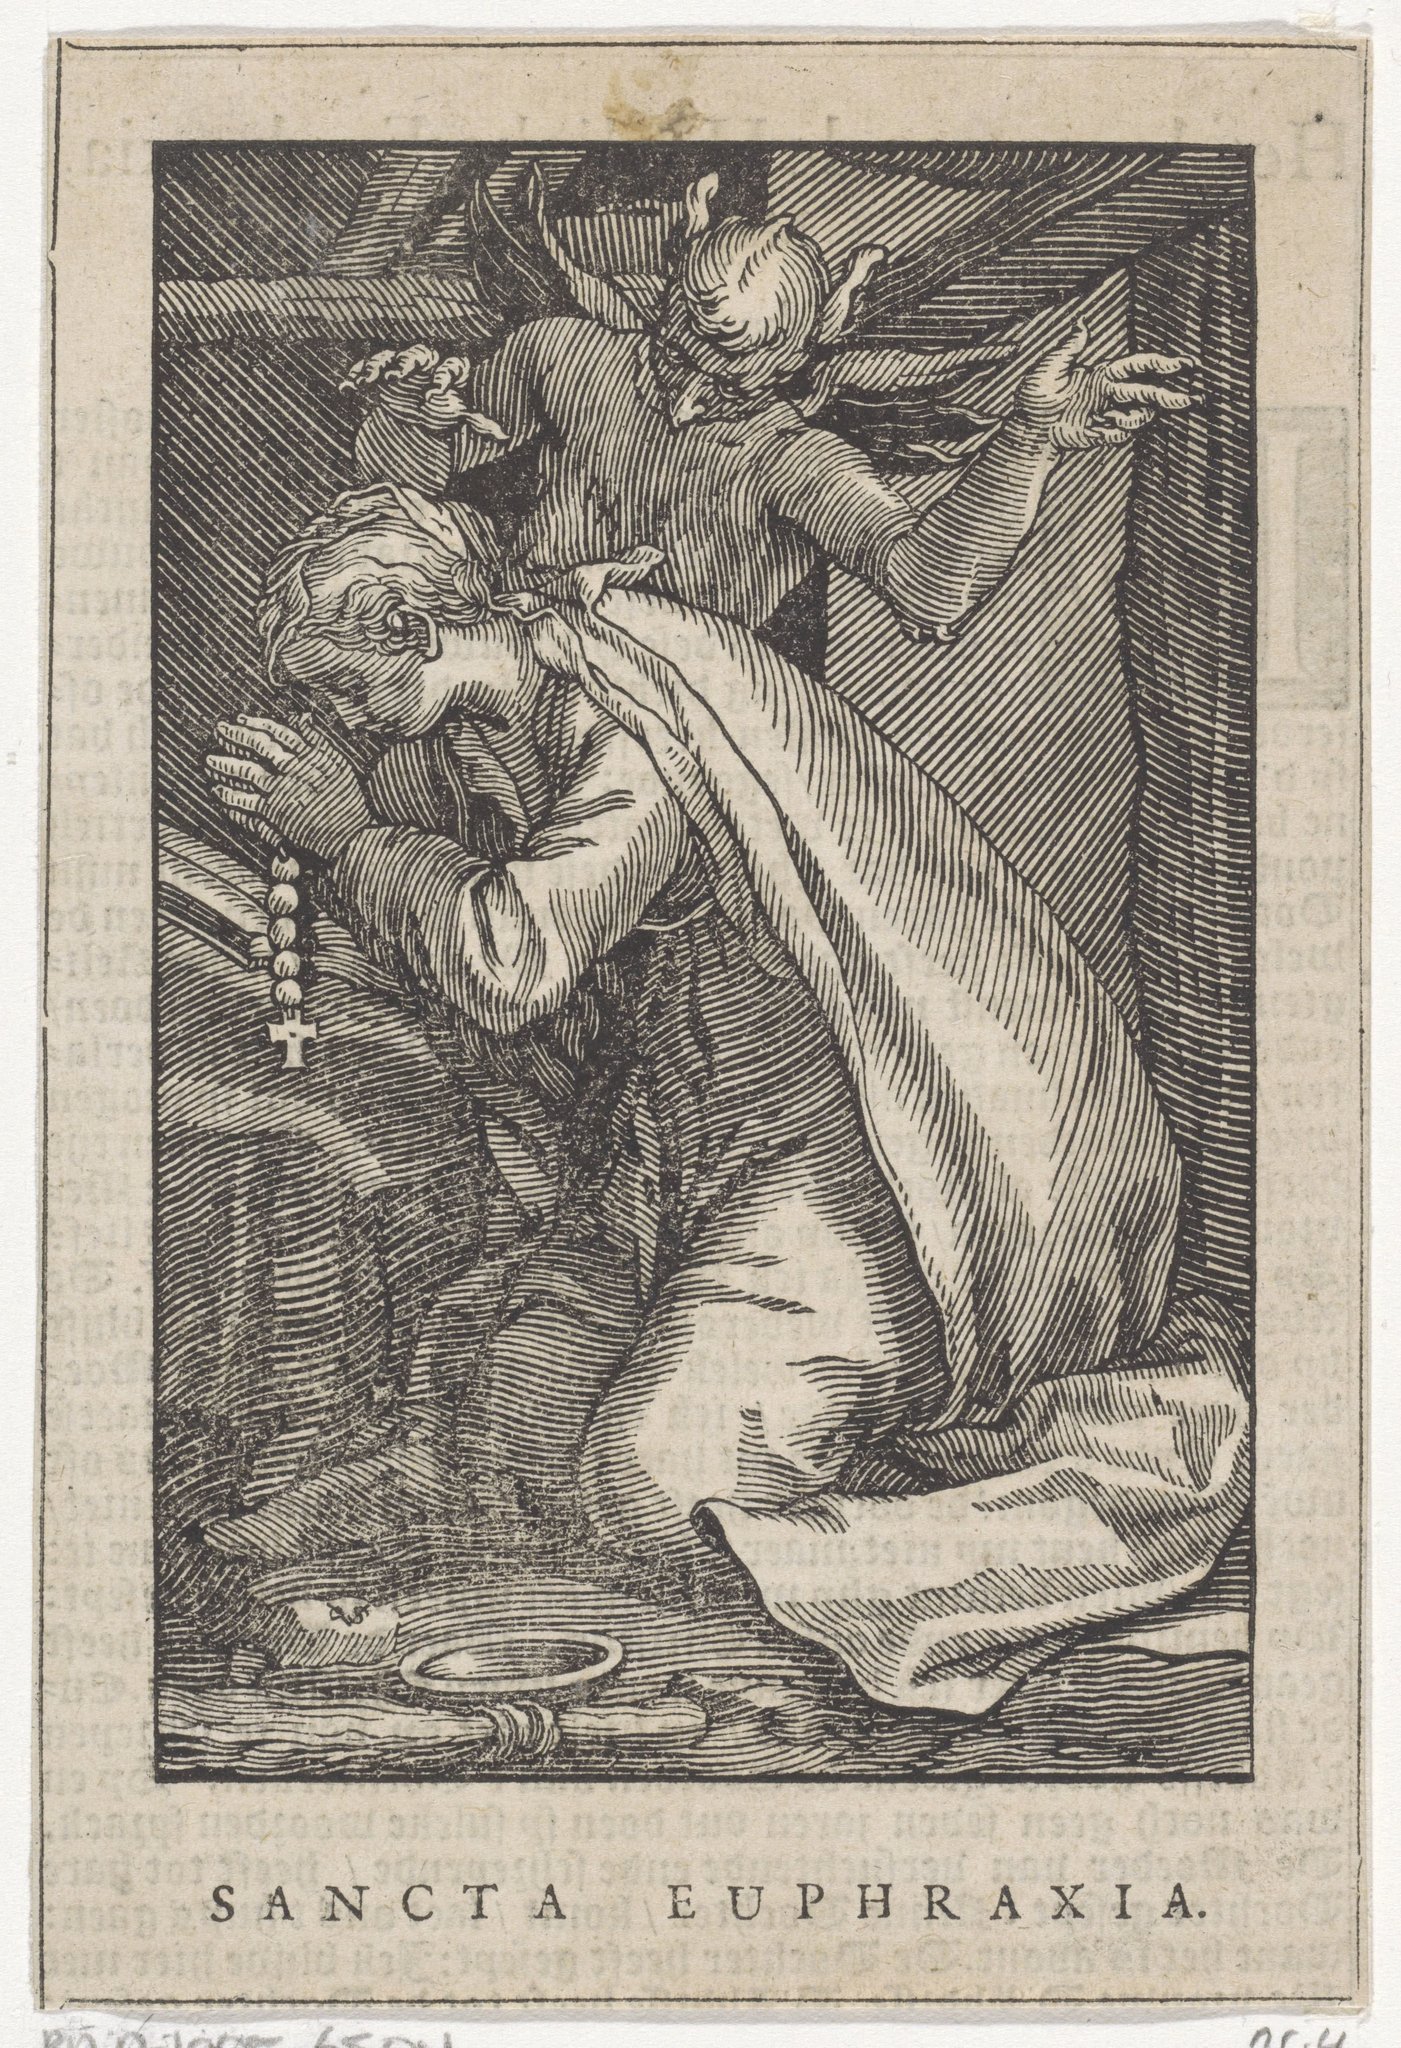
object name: print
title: Heilige Euphrasia van Constantinopel als kluizenares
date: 1644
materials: paper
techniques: letterpress printing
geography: amsterdam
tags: anchorite, hermit, female saints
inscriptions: collector's mark: Lugt 2228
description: Prent uit: Rosweyde, Heribert. 'tBosch der eremyten ende eremitinnen, van Aegypten ende Palestinen. Amsterdam: Pieter Jacobsz. Paets, 1644.